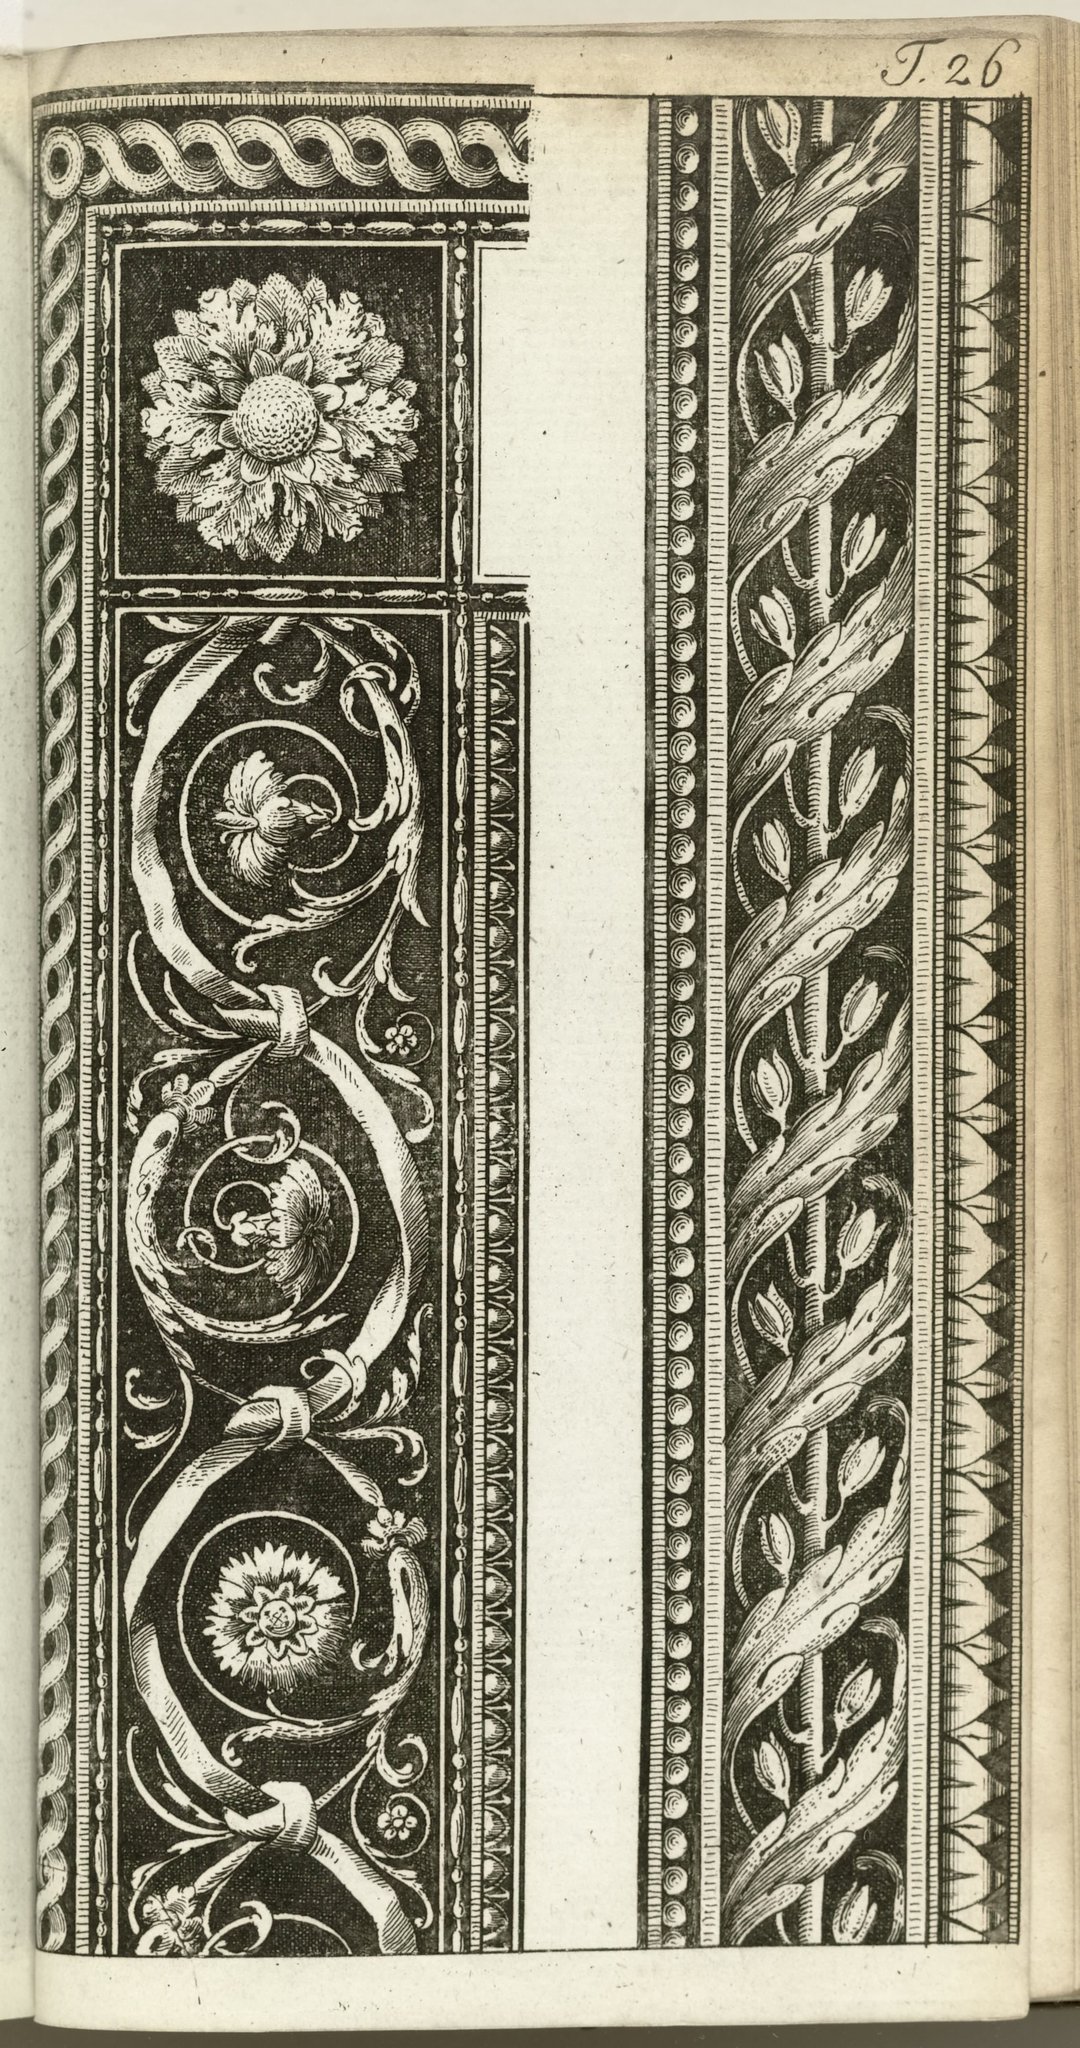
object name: magazine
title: Journal des Luxus und der Moden 1790, Band V, T.26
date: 1790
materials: paper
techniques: etching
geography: weimar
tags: fashion plates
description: Prent uit het modetijdschrift Journal des Luxus und der Moden, uitgegeven door Friedrich Justin Bertuch en Georg Melchior Kraus, Weimar, 1786-1826.